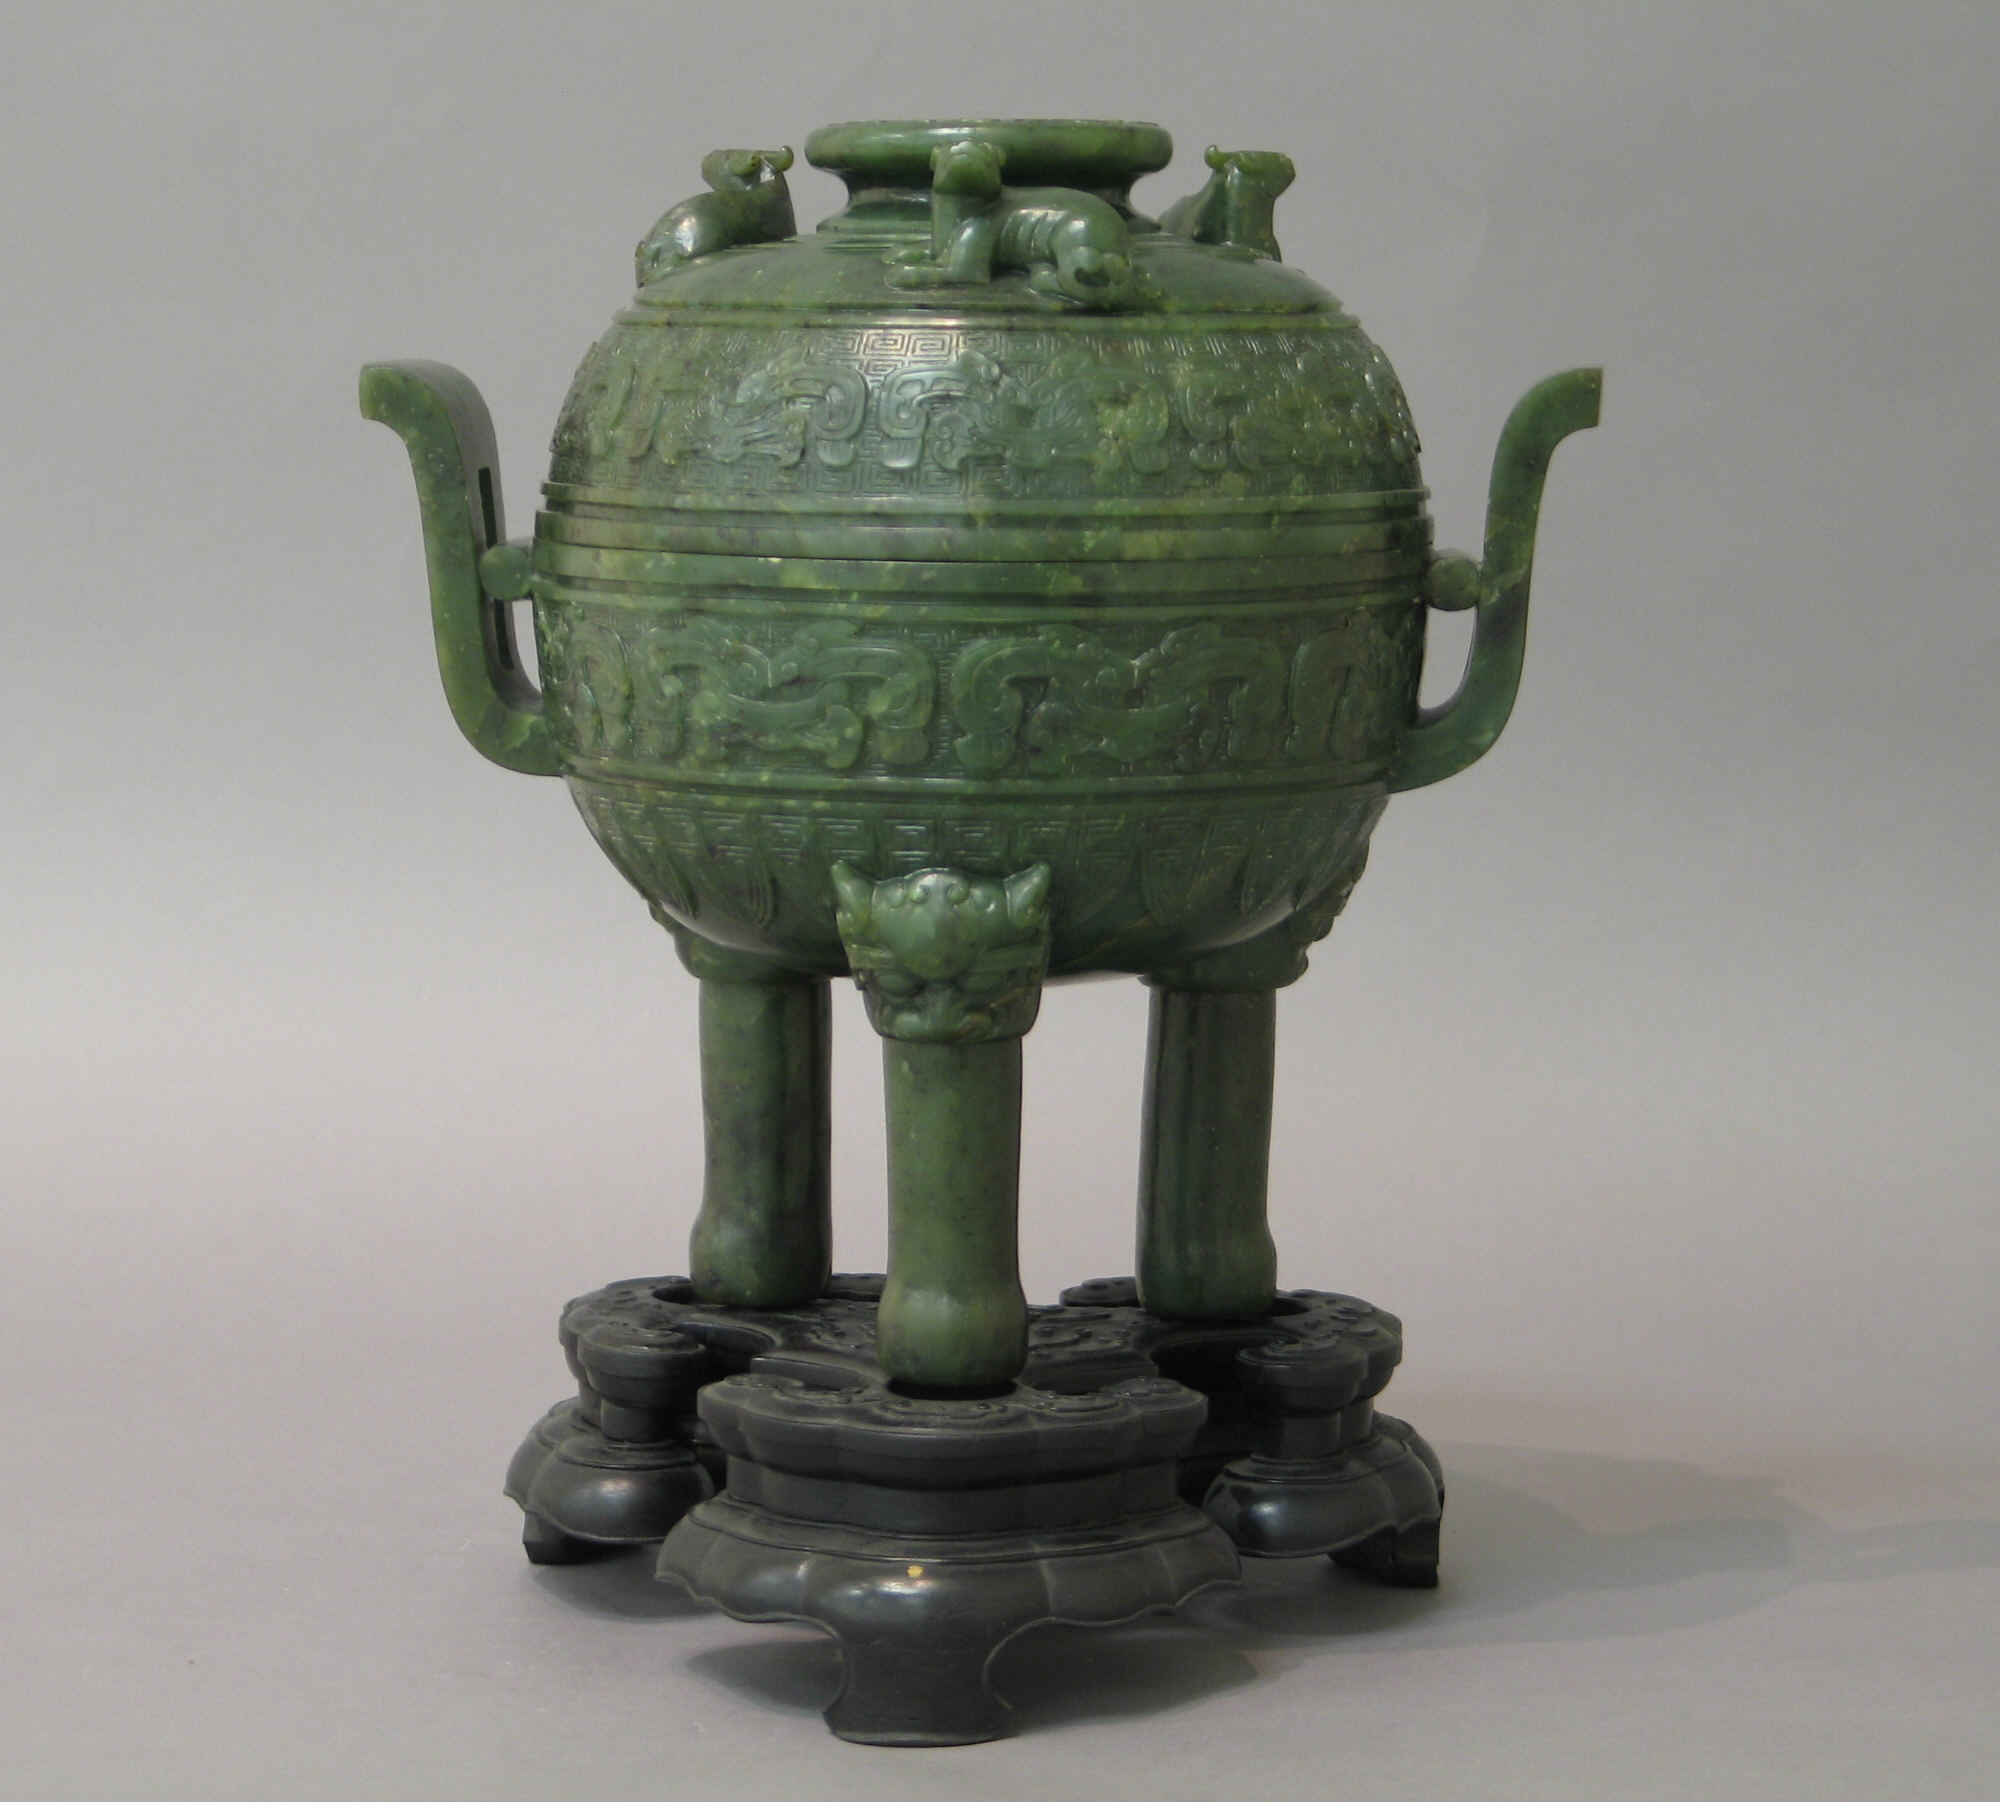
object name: tripod with cover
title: Sacrificial Tripod with Cover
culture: chinese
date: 1736-1795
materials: jade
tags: animals